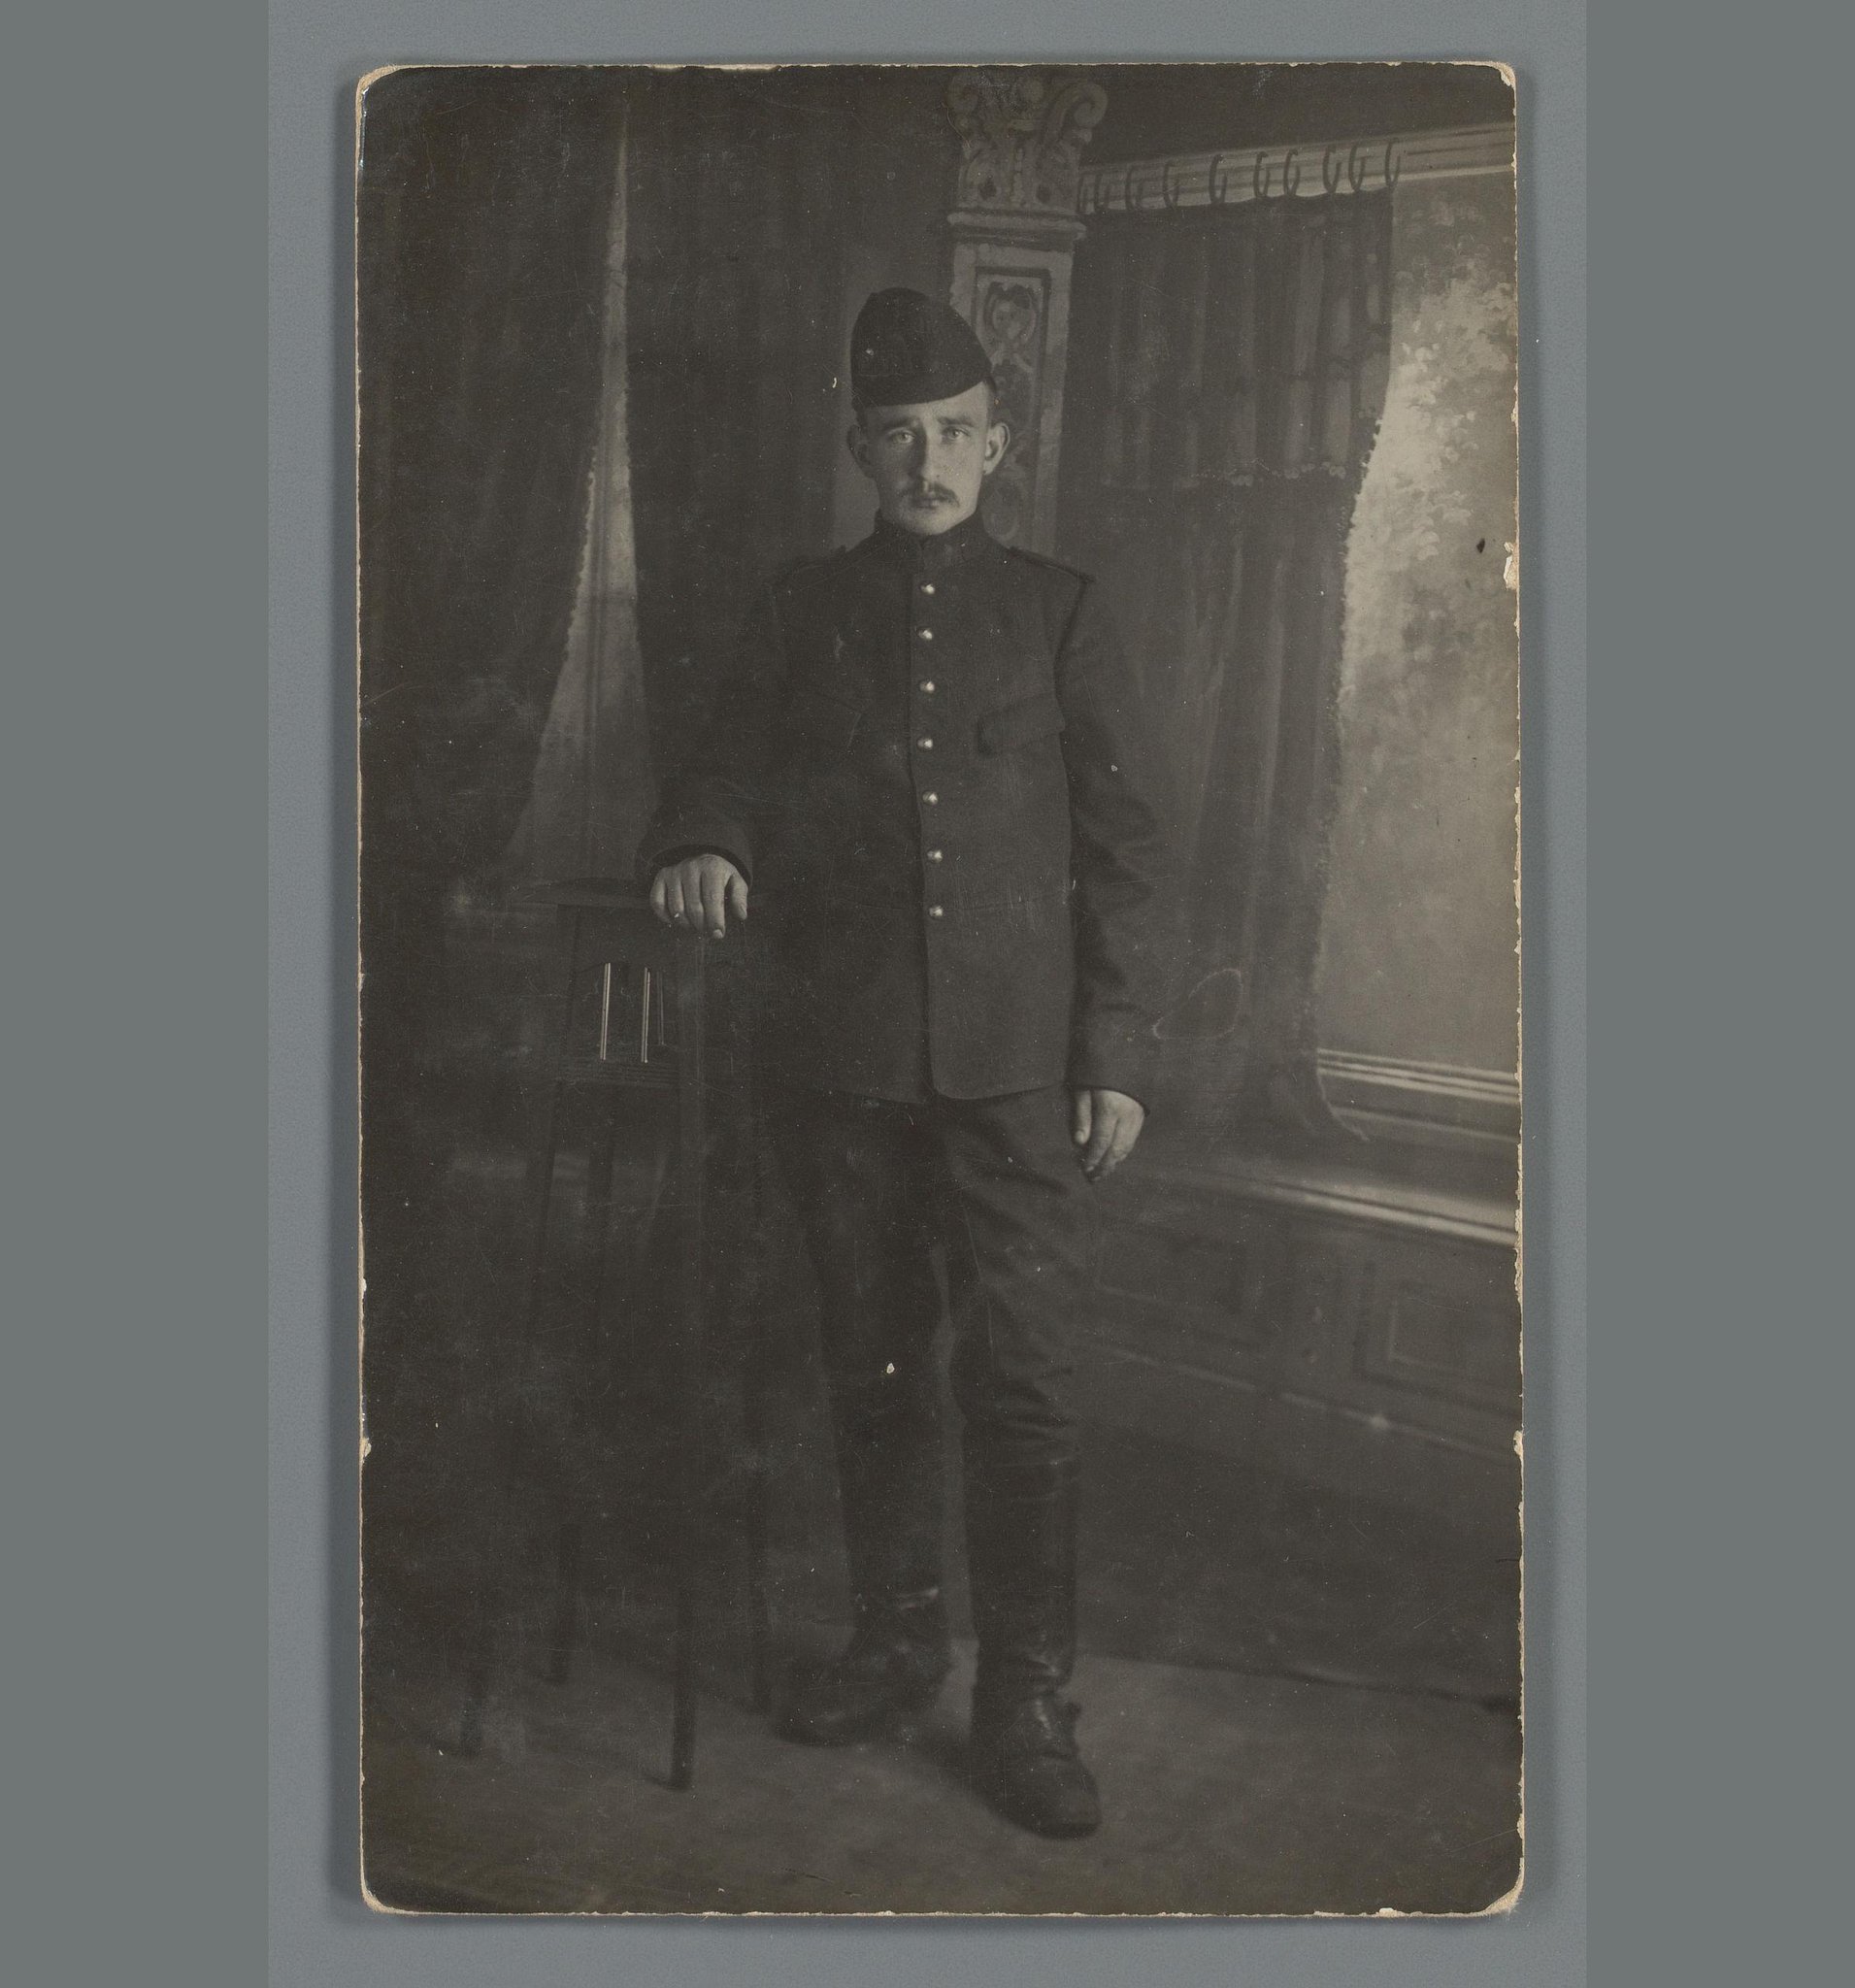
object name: ansichtkaart, prentbriefkaart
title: Portret van een onbekende man in militair uniform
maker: Anonymous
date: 1905-1920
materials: paper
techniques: gelatin silver print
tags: (military) uniforms, historical persons not known by name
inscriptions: inscription: ‘25 jaar’